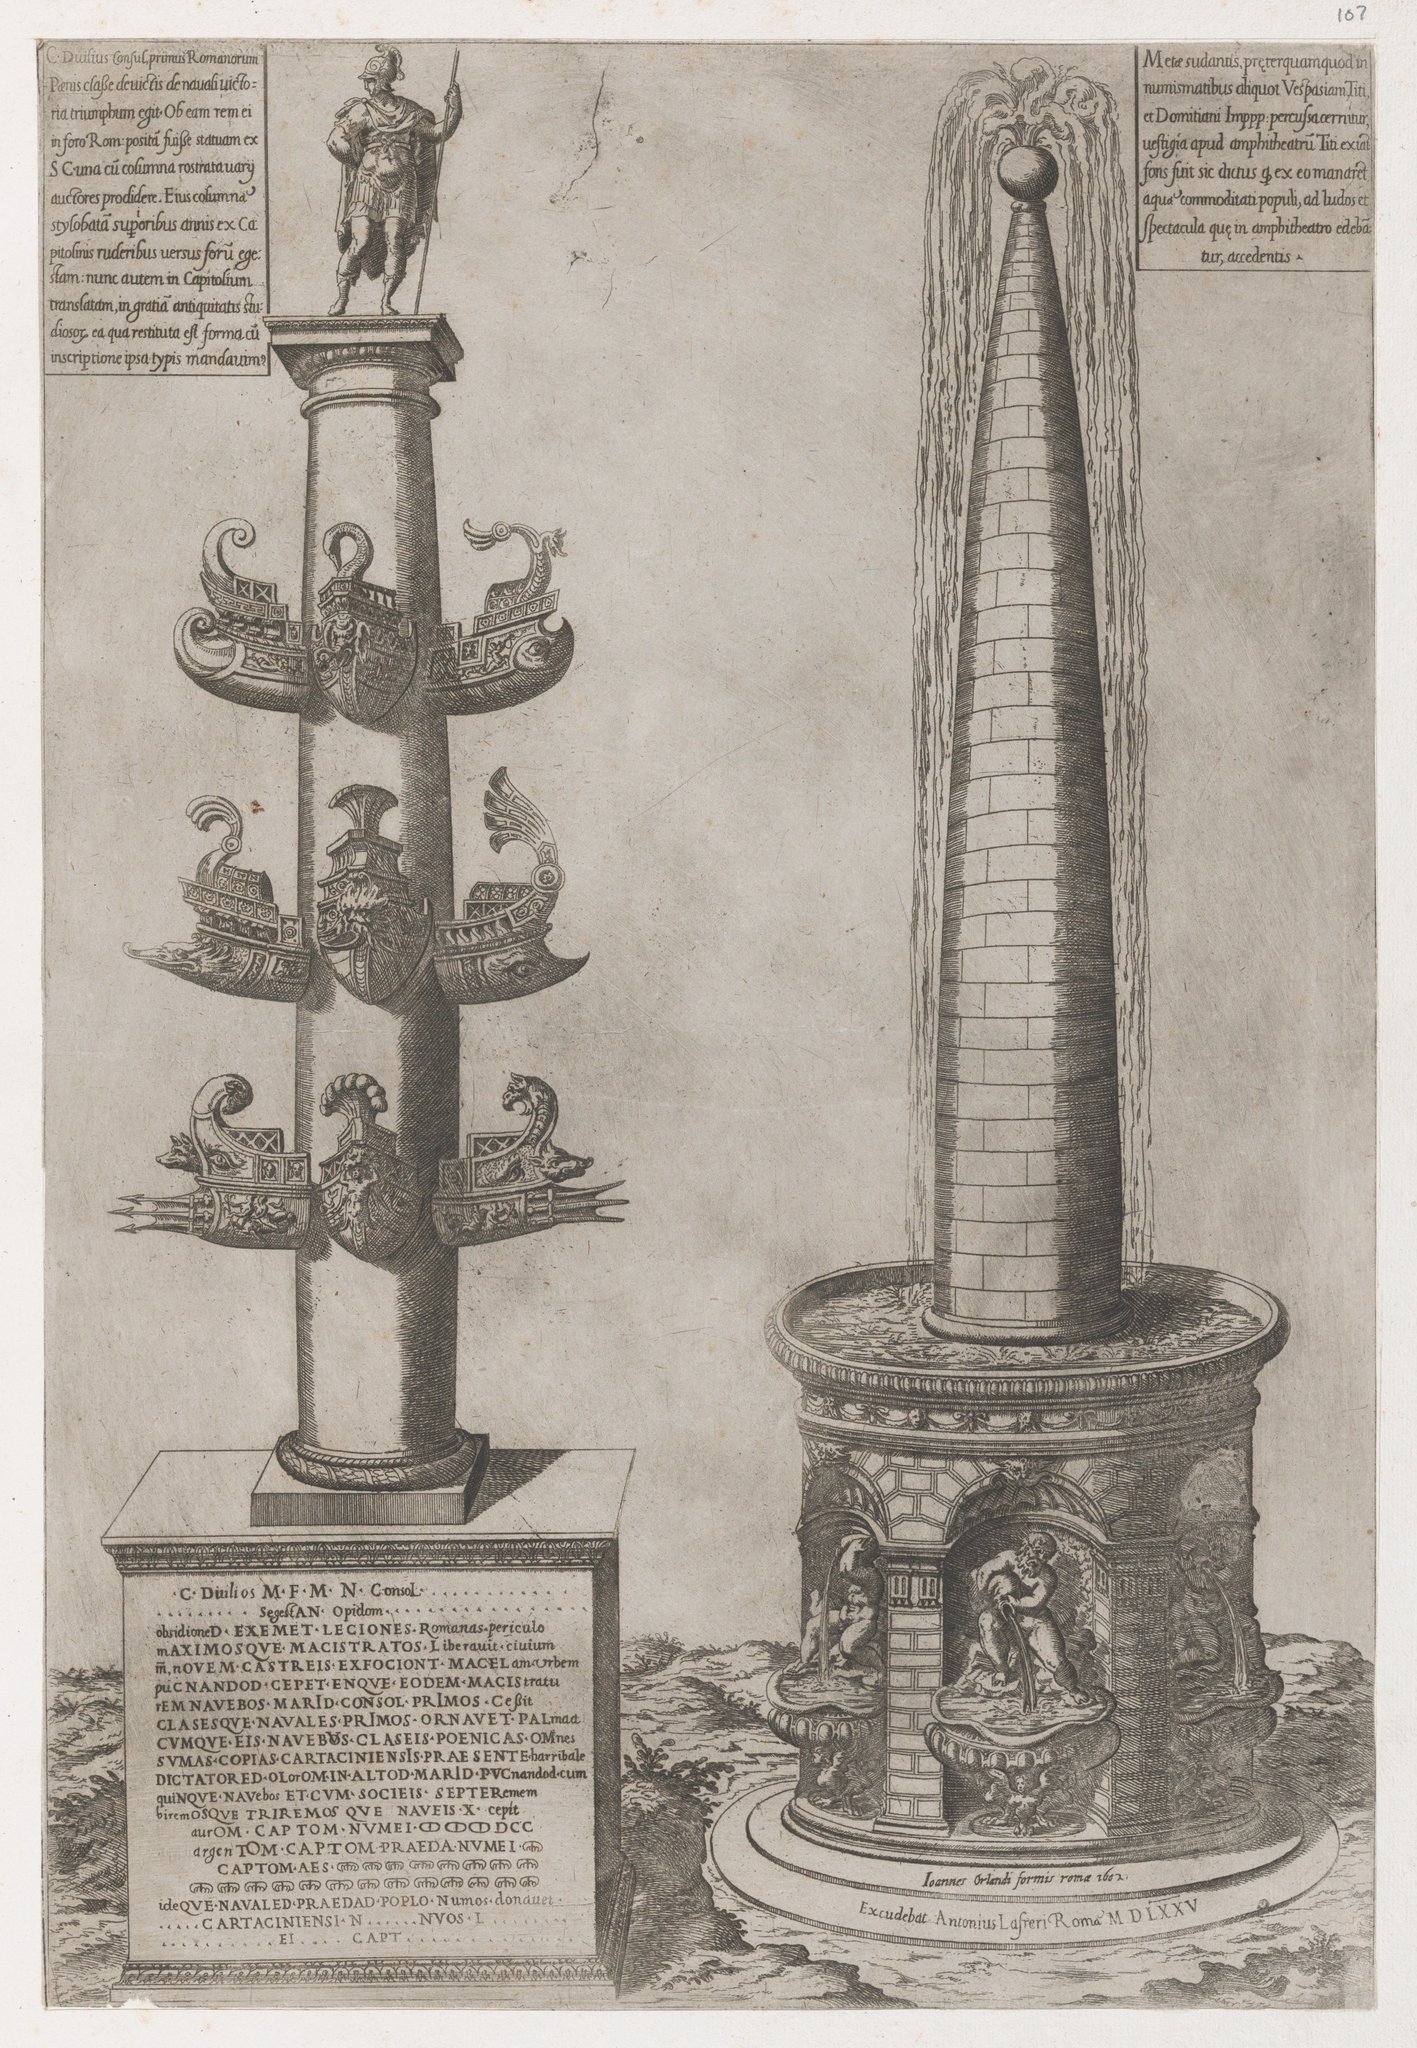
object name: print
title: Column of Duilius, from "Speculum Romanae Magnificentiae"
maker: Anonymous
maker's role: artist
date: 1575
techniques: etching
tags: columns,rome